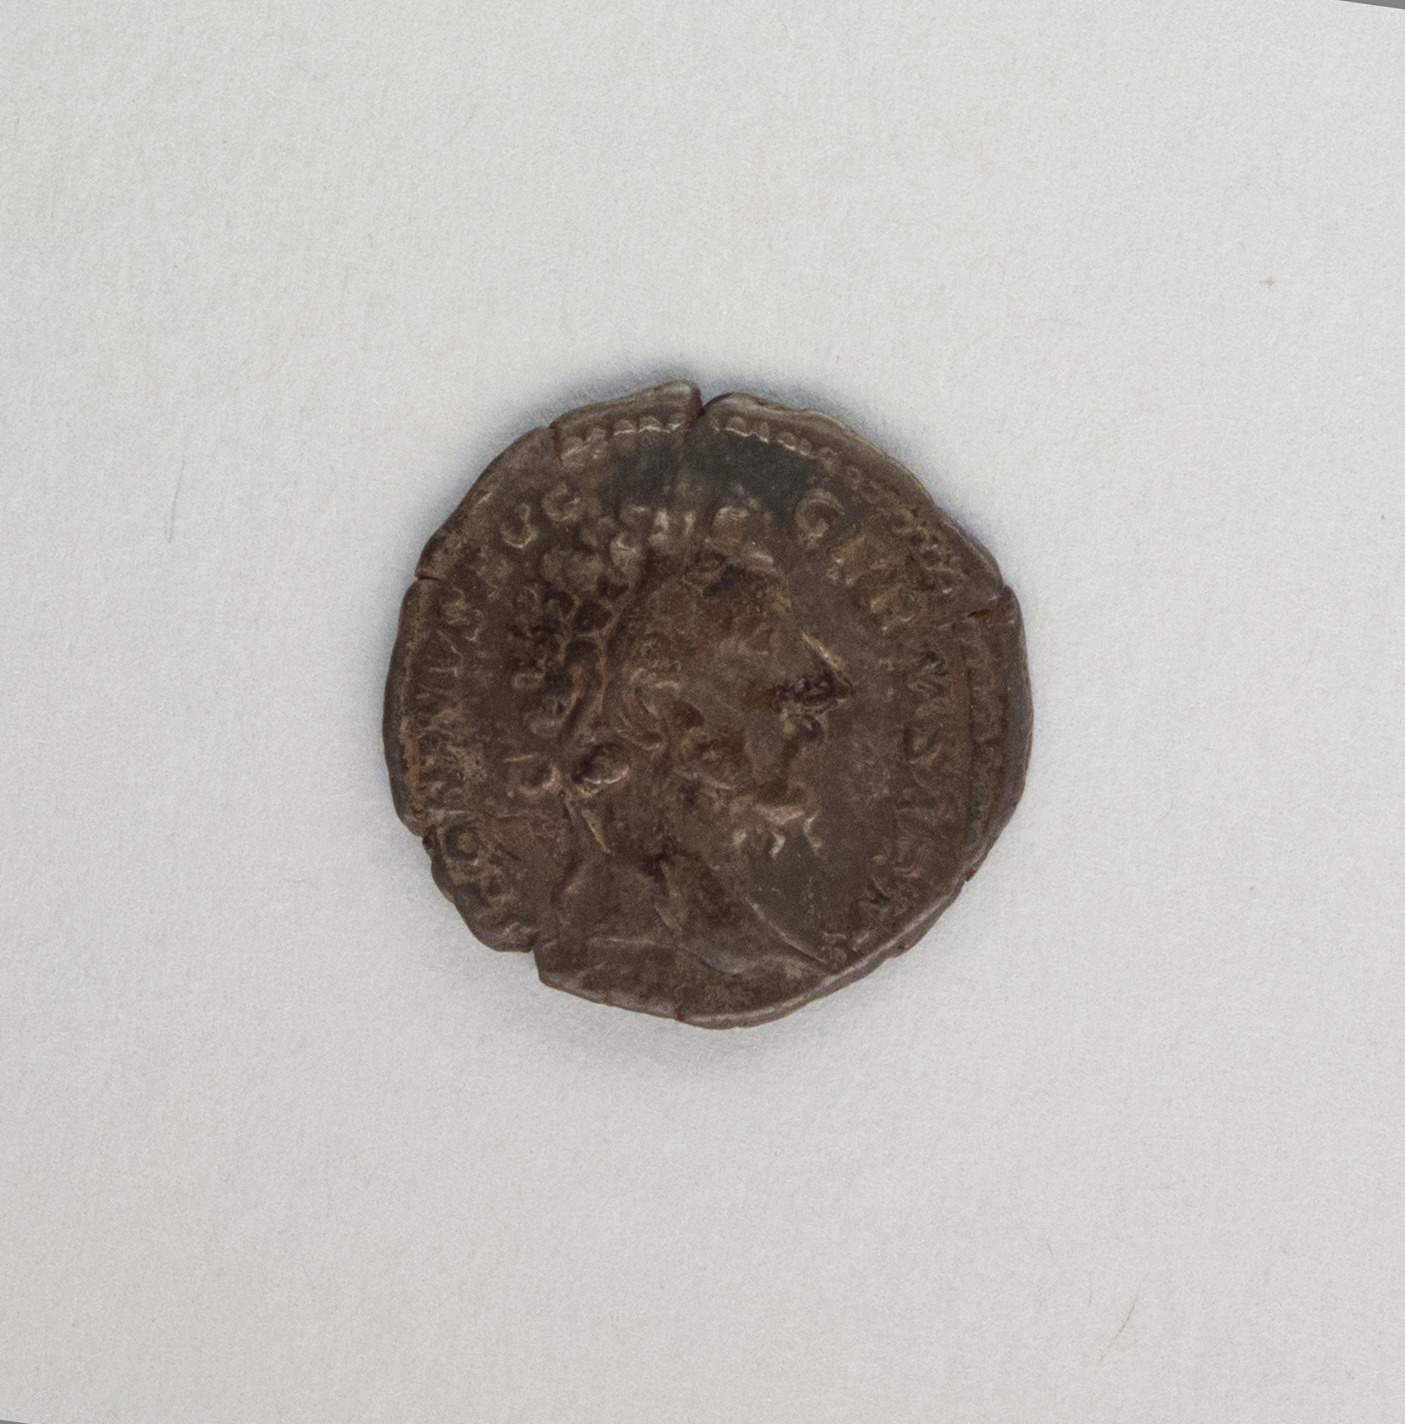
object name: denarius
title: Silver denarius of Marcus Aurelius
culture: roman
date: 176-177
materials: silver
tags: men,profiles